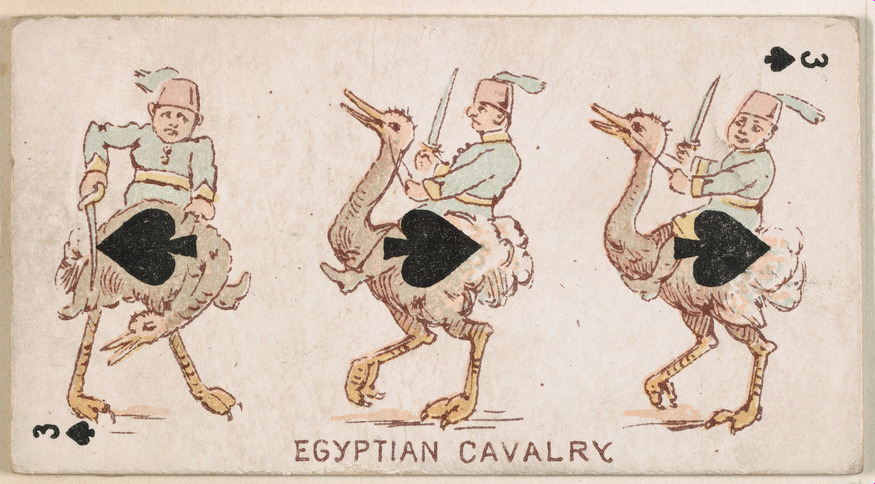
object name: print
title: Three of Spades, Egyptian Cavalry, from Harlequin Cards, 2nd Series (N220) issued by Kinney Bros.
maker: kinney brothers tobacco company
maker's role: publisher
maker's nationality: american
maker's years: 1869-2011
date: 1889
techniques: color lithograph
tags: birds,men,playing cards